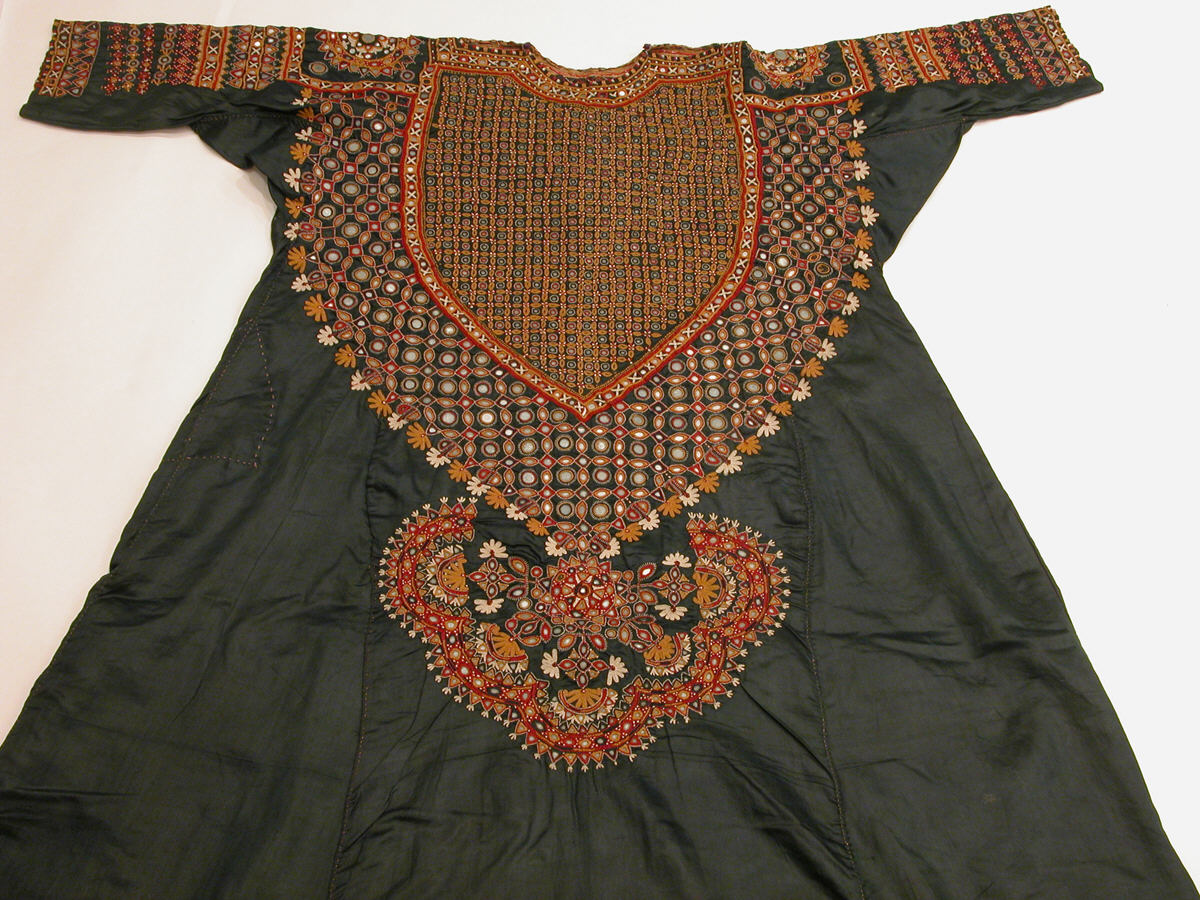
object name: dress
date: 1801-1900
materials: silk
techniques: embroidery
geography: india